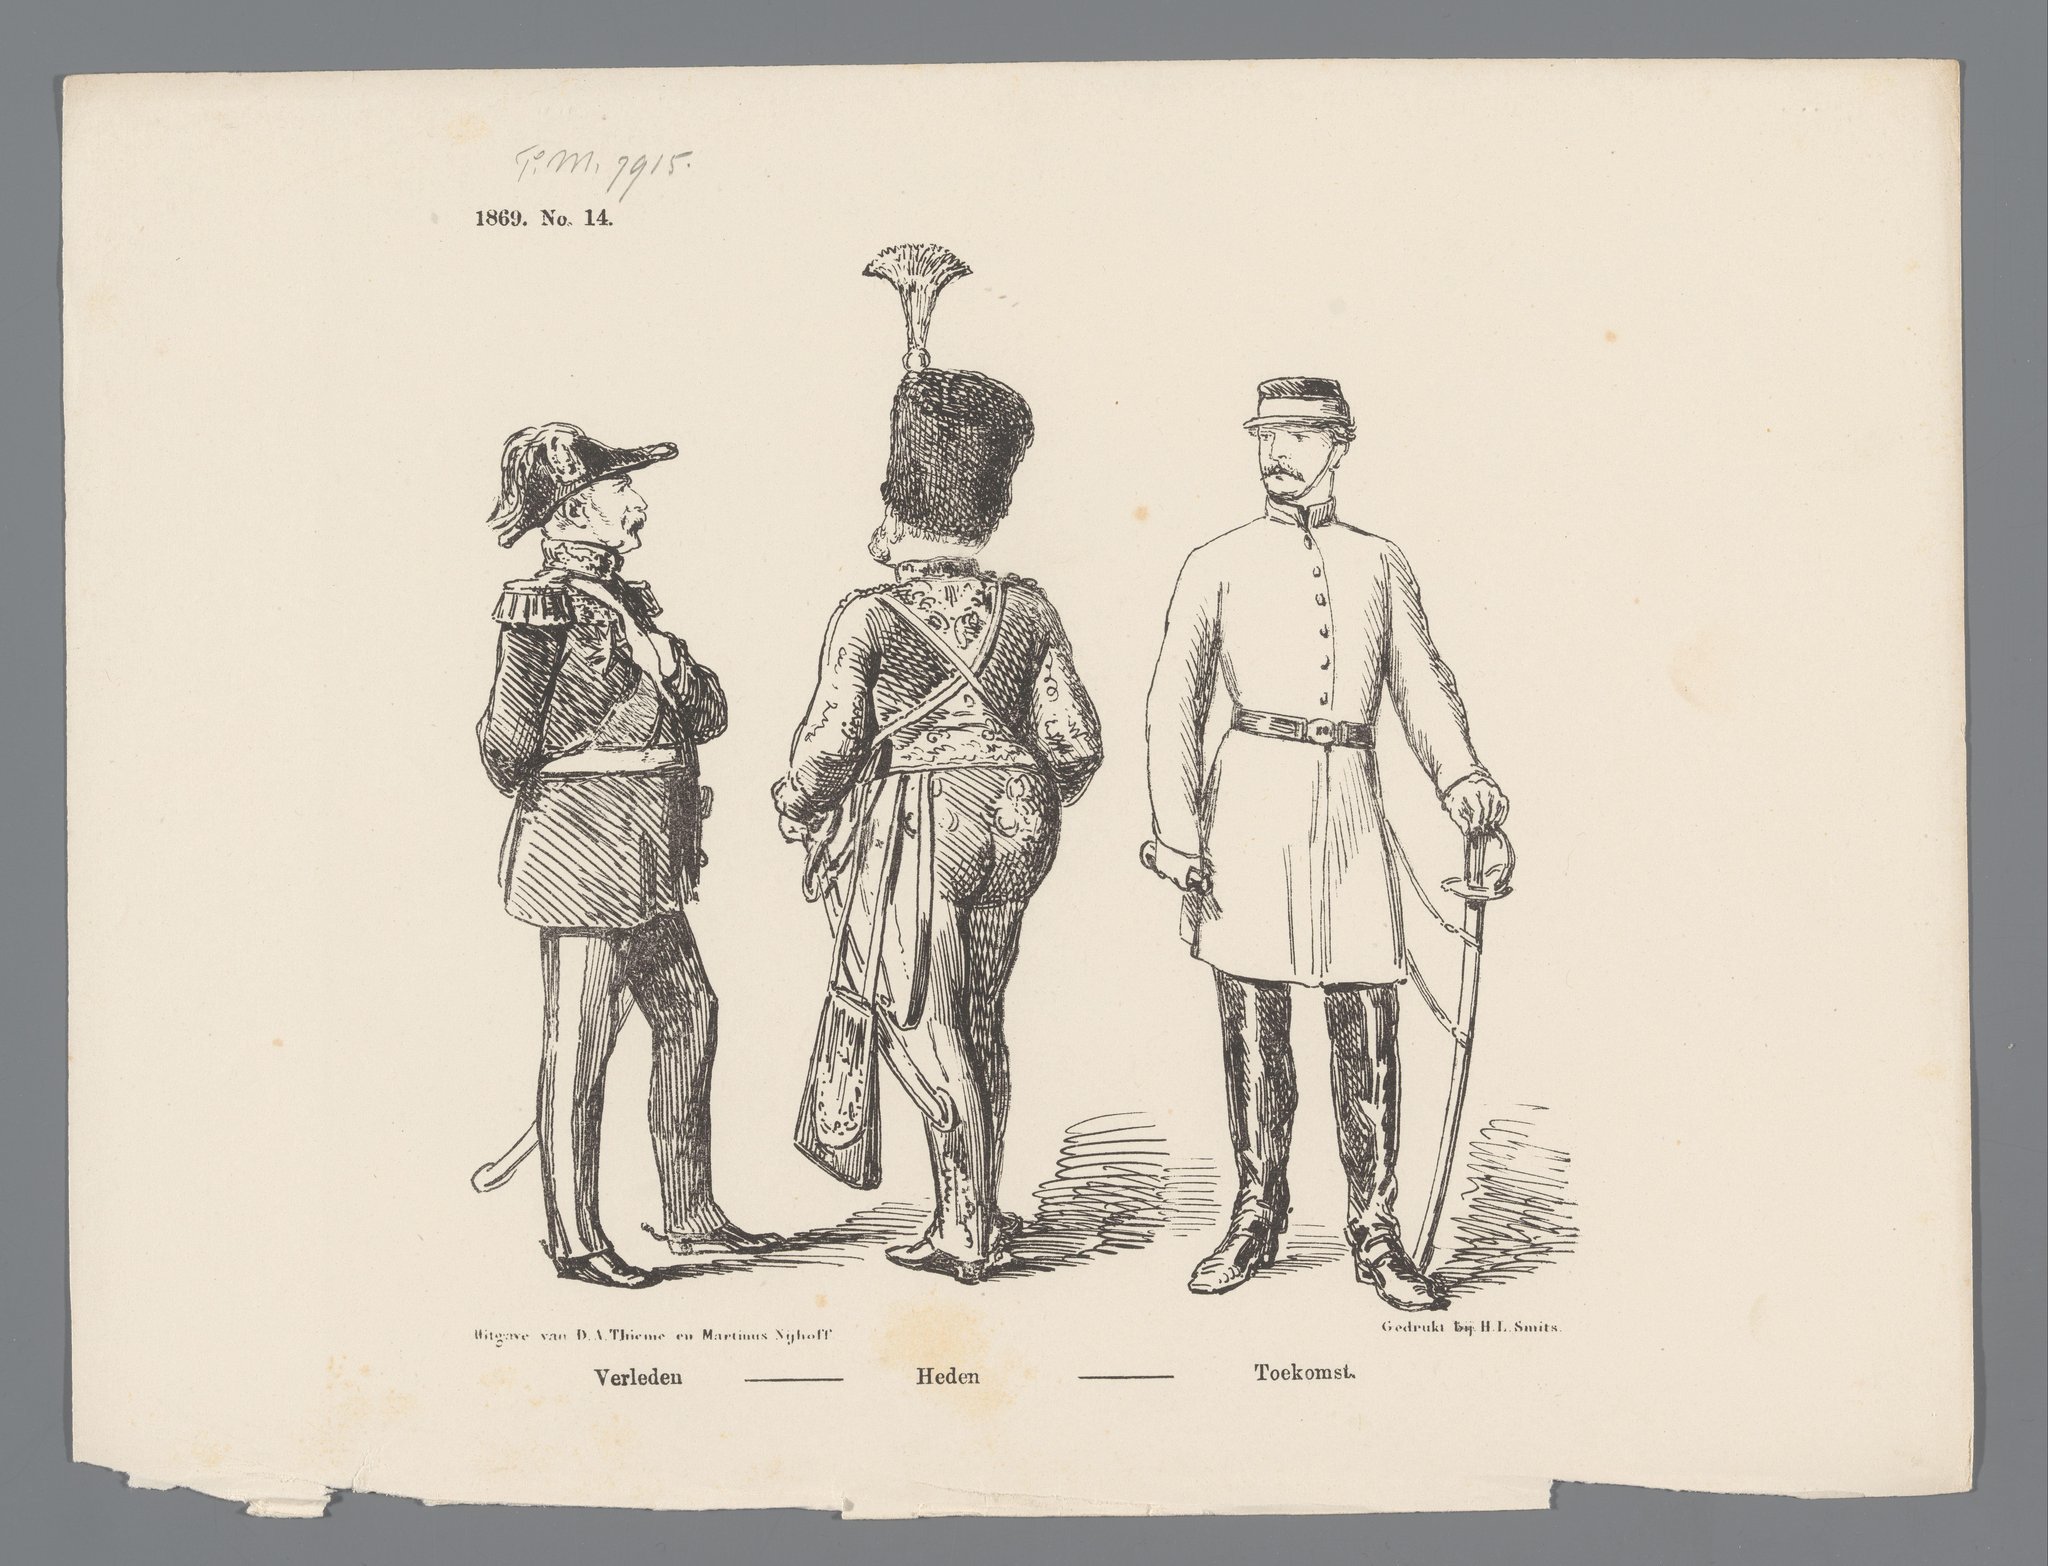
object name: print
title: Verleden - Heden - Toekomst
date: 1869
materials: paper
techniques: lithograph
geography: netherlands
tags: (military) uniforms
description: Spotprent over het nieuwe Nederlandse militaire uniform en hoe deze verbeterd en vereenvoudigd zou kunnen worden. Plaat verschenen bij het weekblad De Nederlandsche Spectator, nr. 14, 1869.